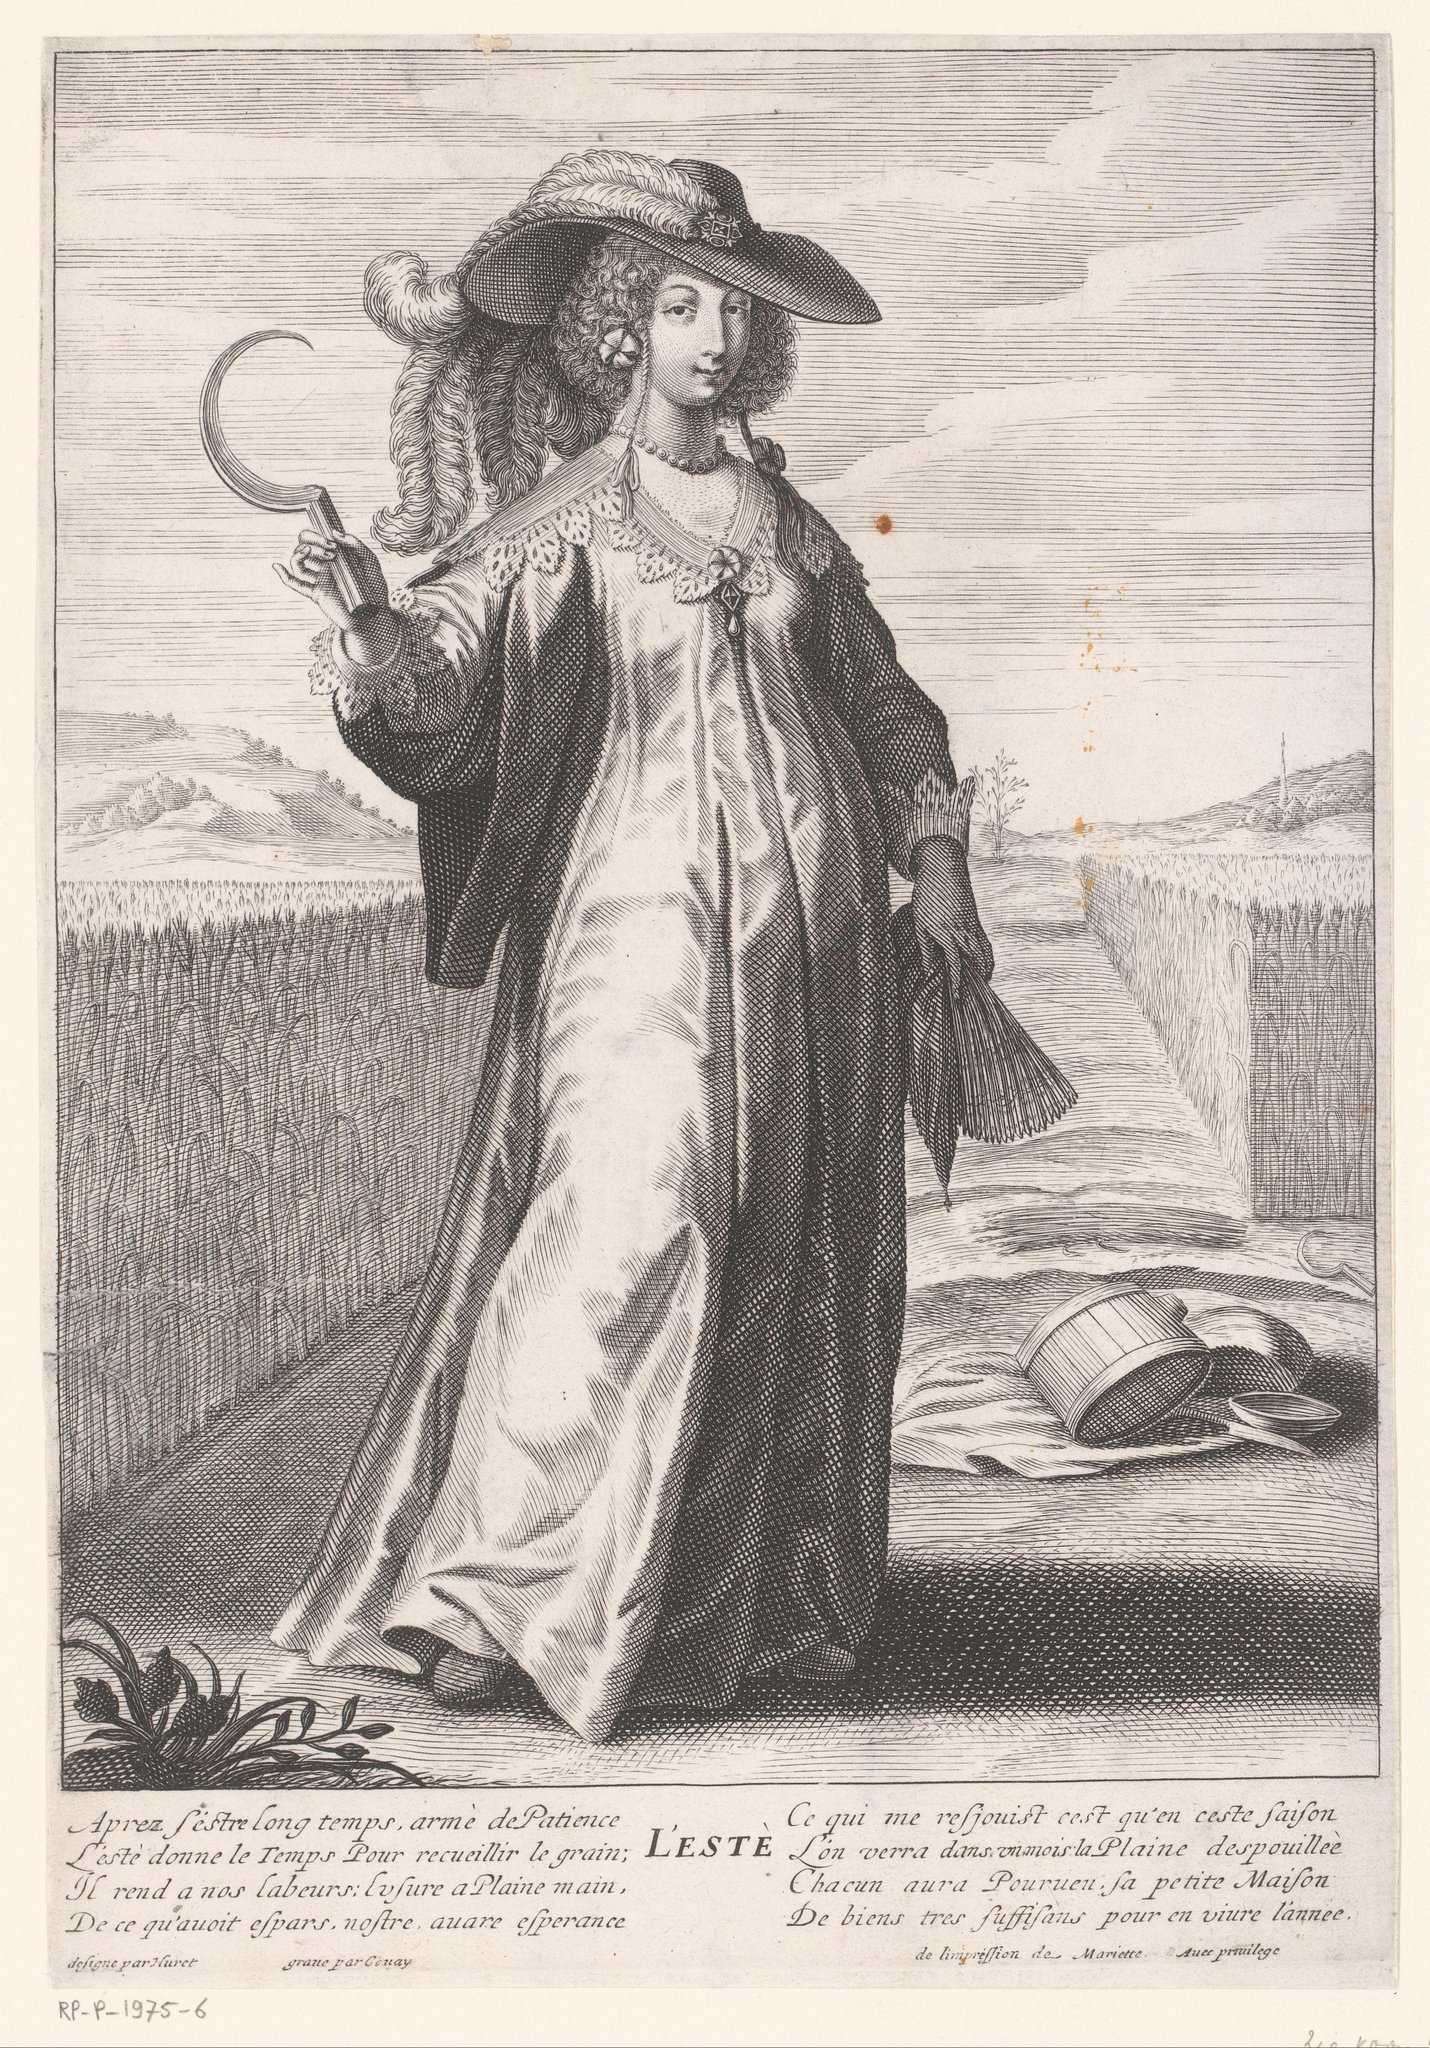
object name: print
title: L'Estè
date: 1632-1657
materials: paper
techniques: engraving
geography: france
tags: year divided into four seasons, summer, 'aestas'; 'estate' (ripa), cereal, grain, corn (grass with grains, grown for food, e.g.: wheat, rice, rye, oats, maize, buckwheat, millet), agricultural implements: sickle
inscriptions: collector's mark: Lugt 2760, collector's mark: Lugt 2228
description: Maakt deel uit van een vierdelige serie met personificaties van de vier seizoenen. De lente en de zomer zijn vervaardigd door Couvay. De herfst en de winter zijn vervaardigd door Rousselet.